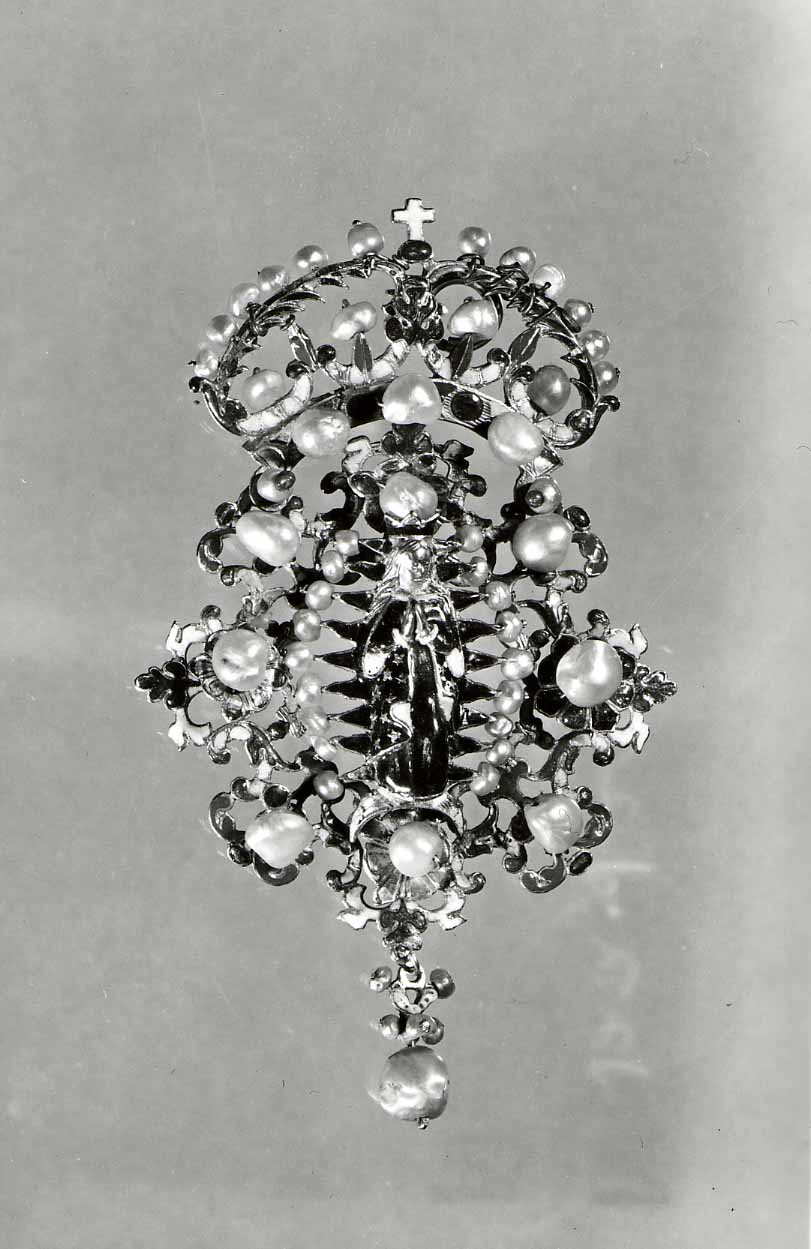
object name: pendant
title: Pendant with the Virgin of the Immaculate Conception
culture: spanish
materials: enamel, gold, pearl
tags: virgin mary